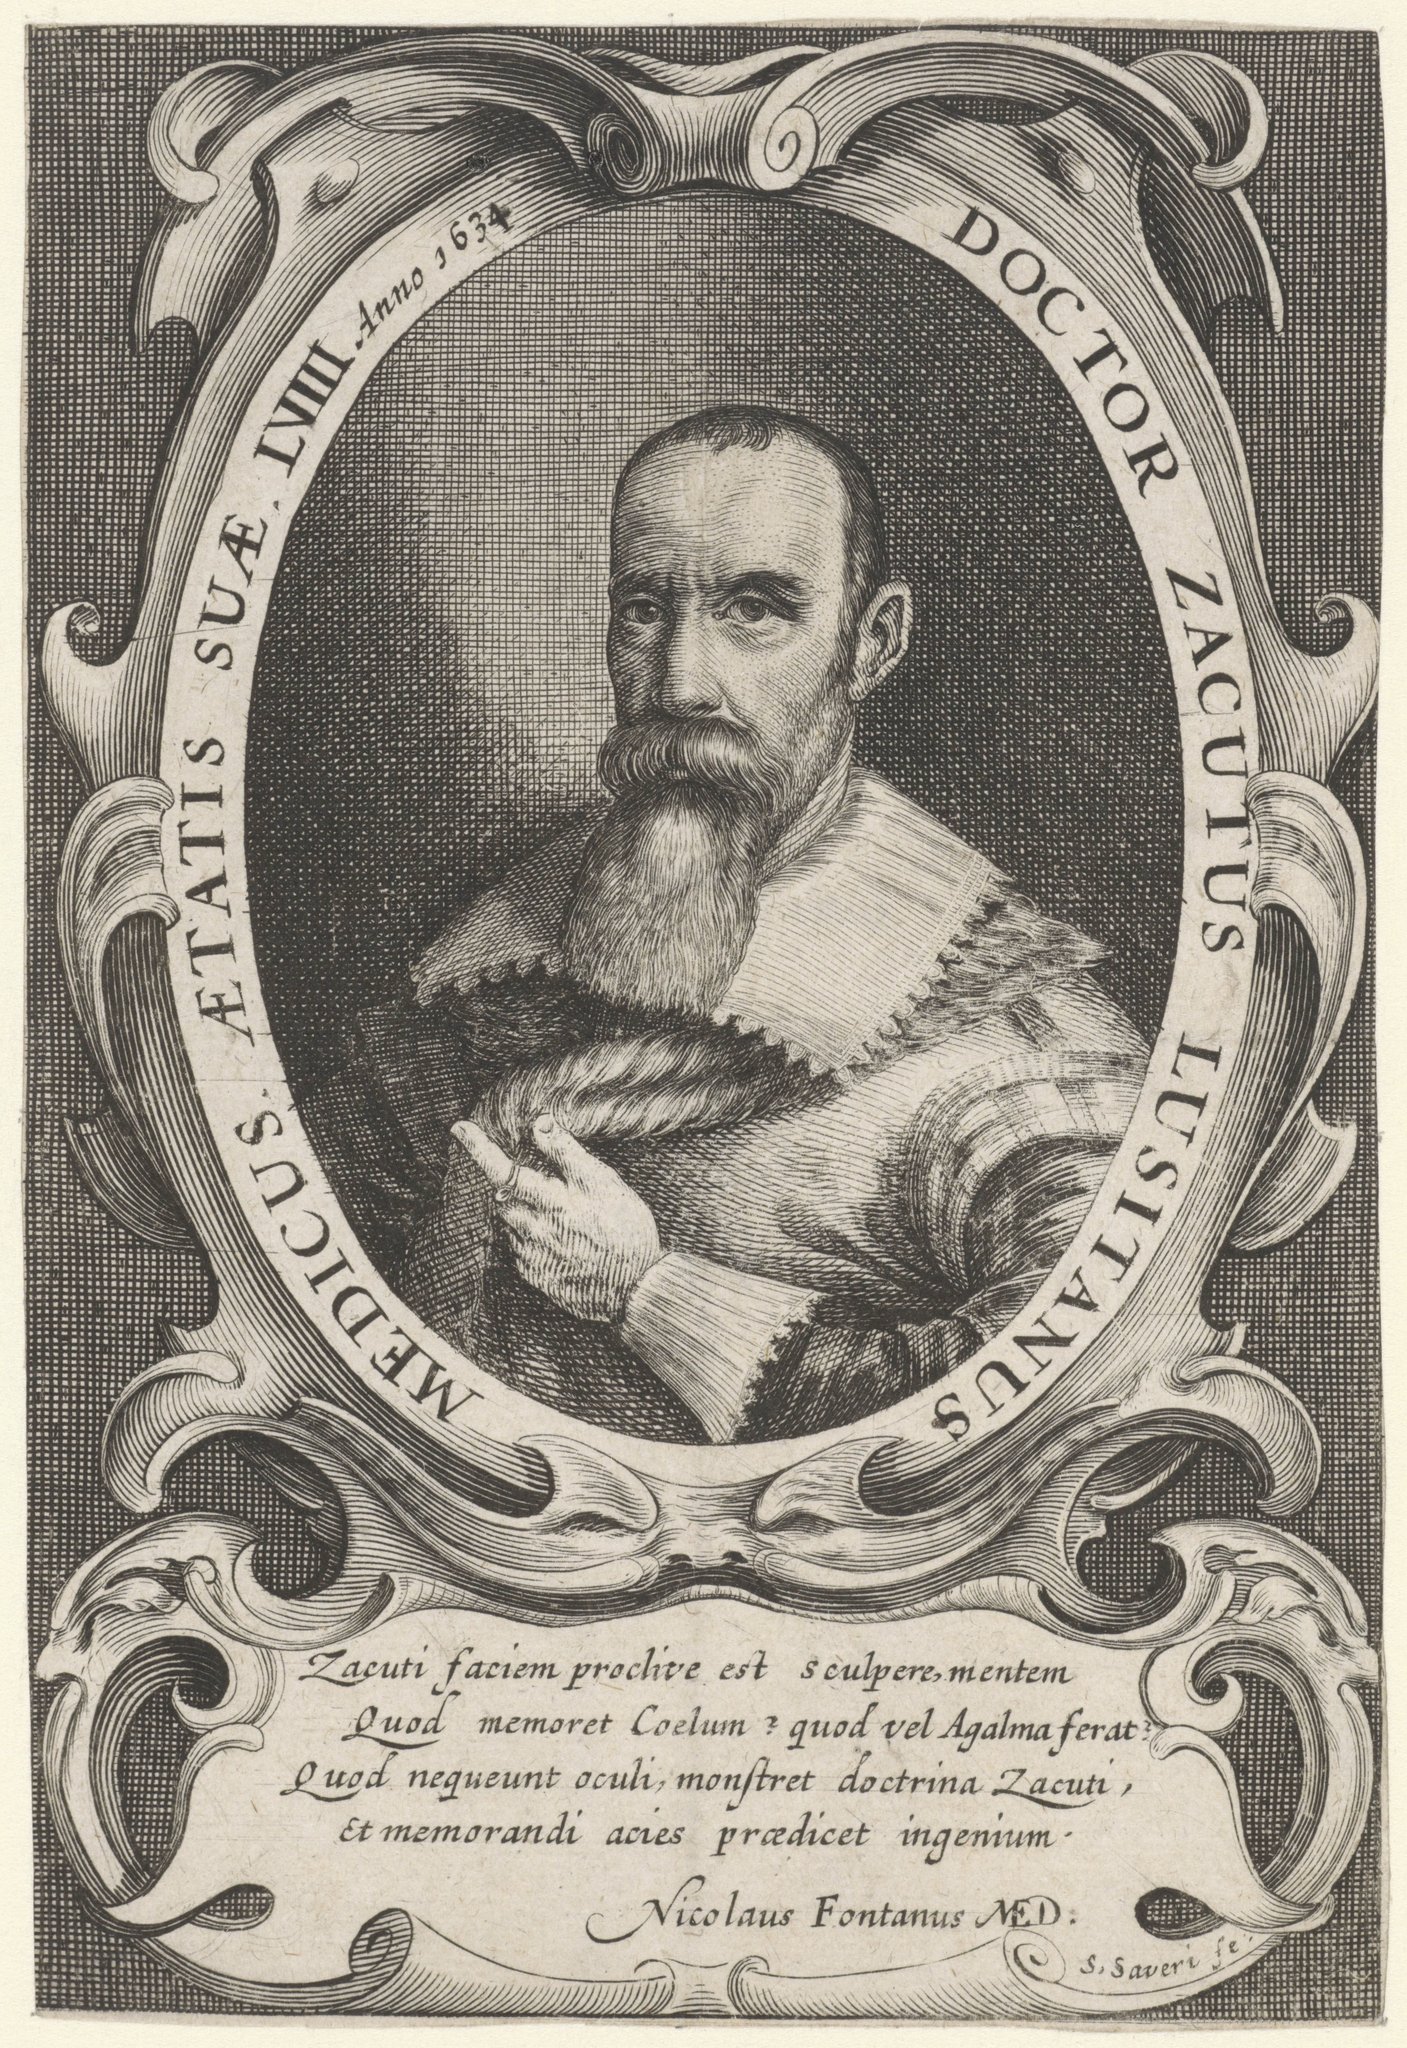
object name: print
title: Portret van de arts Abraham Zacutus Lusitanus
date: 1634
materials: paper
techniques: engraving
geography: amsterdam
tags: abraham zacutus lusitanus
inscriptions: collector's mark: Lugt 2228